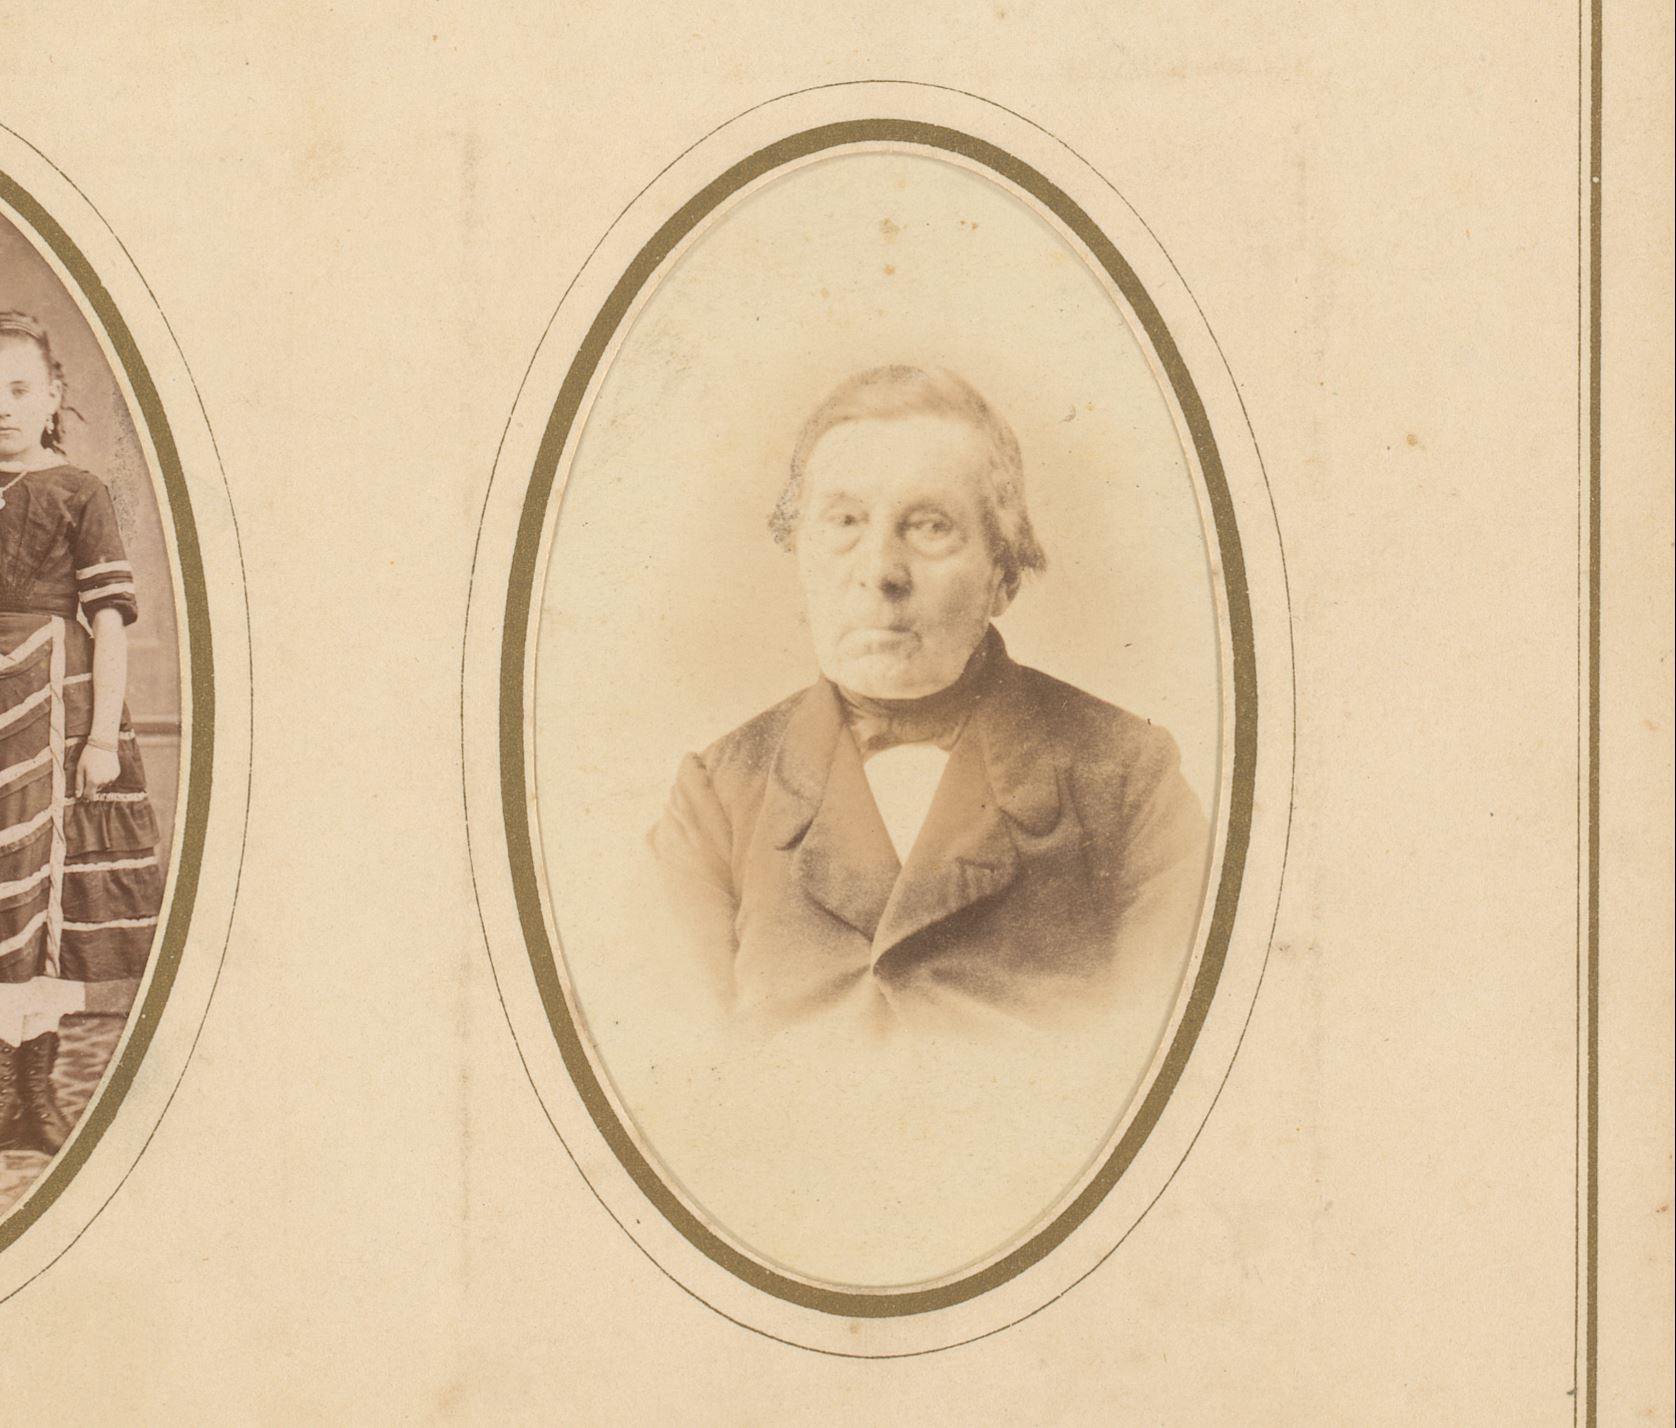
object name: carte de visite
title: Portret van een man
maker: Anonymous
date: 1860-1880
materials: cardboard, photographic support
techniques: albumen print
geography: netherlands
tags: historical persons